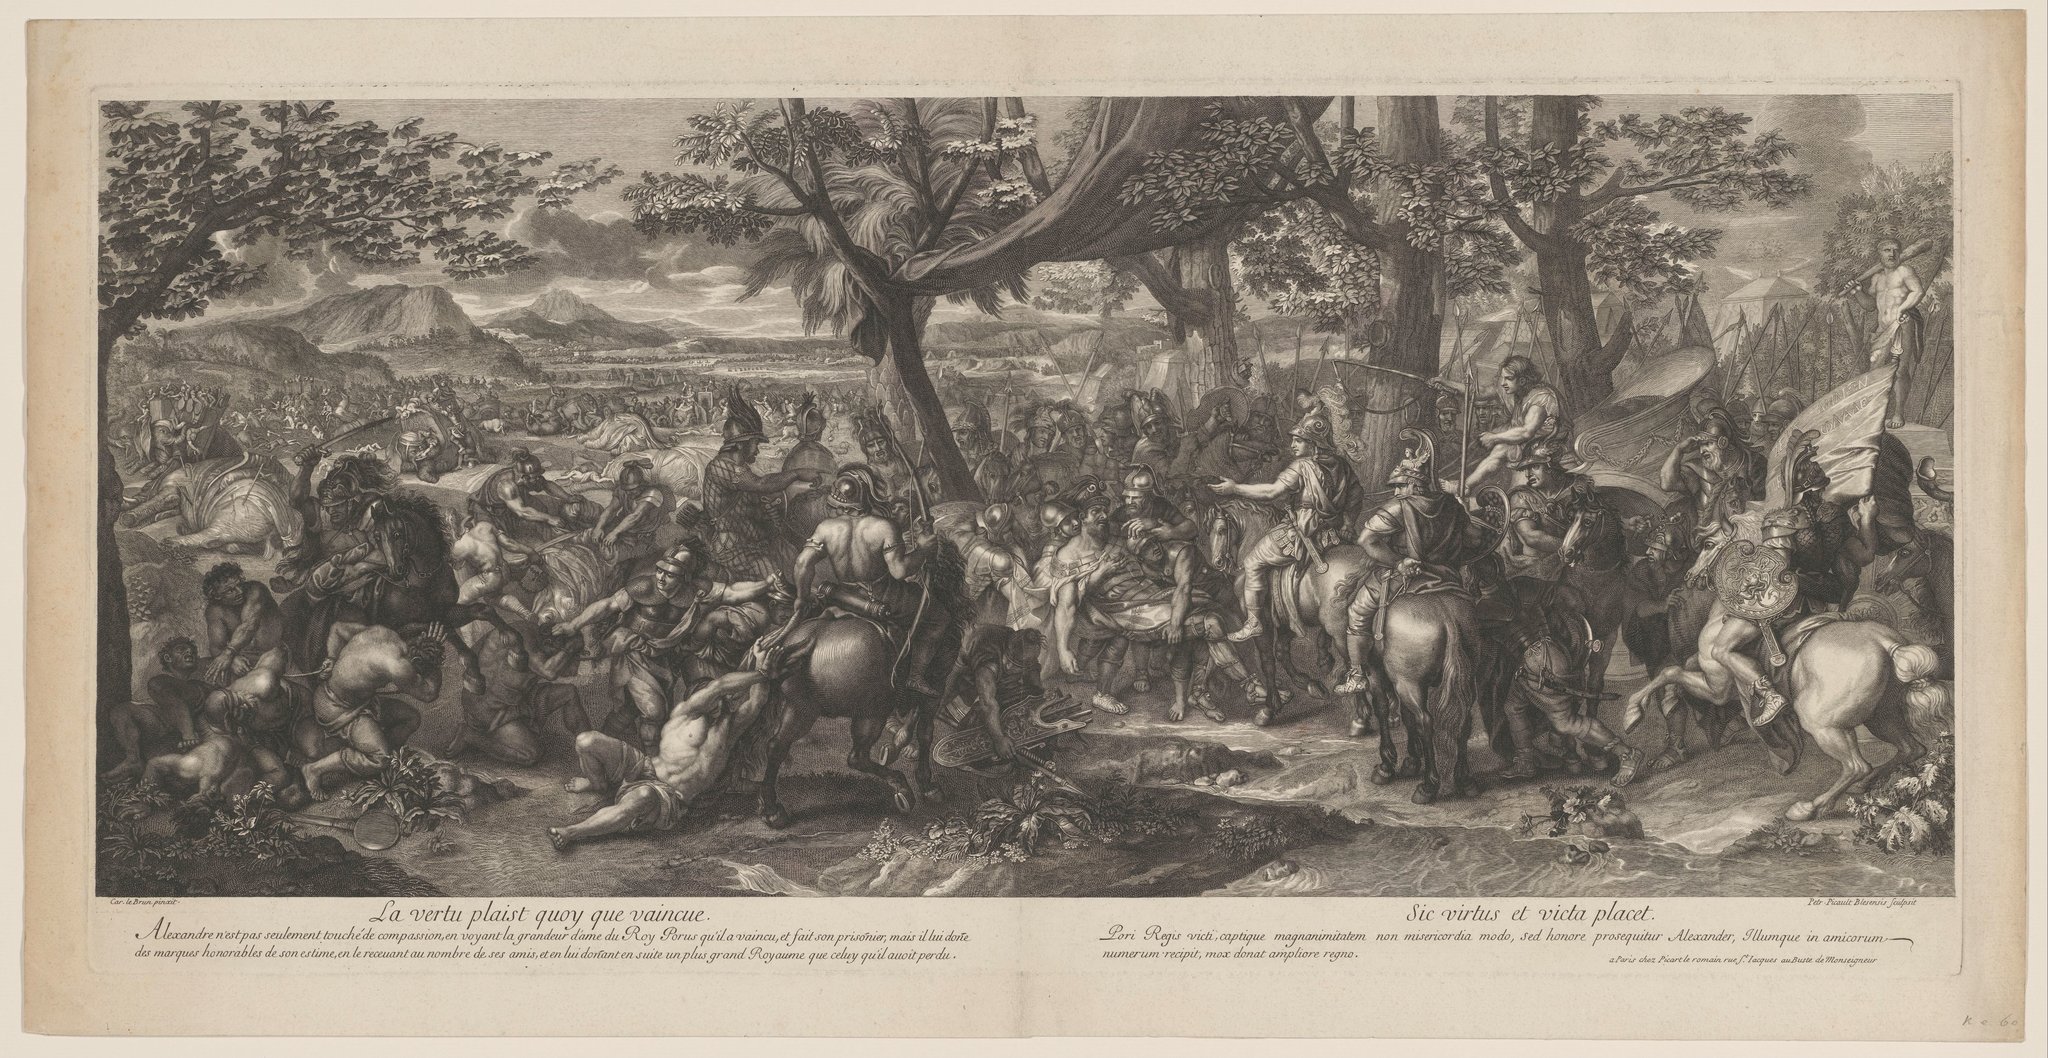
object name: print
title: Poros verwond in de strijd met Alexander de Grote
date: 1690-1711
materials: paper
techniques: engraving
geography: paris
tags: the army of porus and its elephants are conquered by alexander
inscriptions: collector's mark: Lugt 240